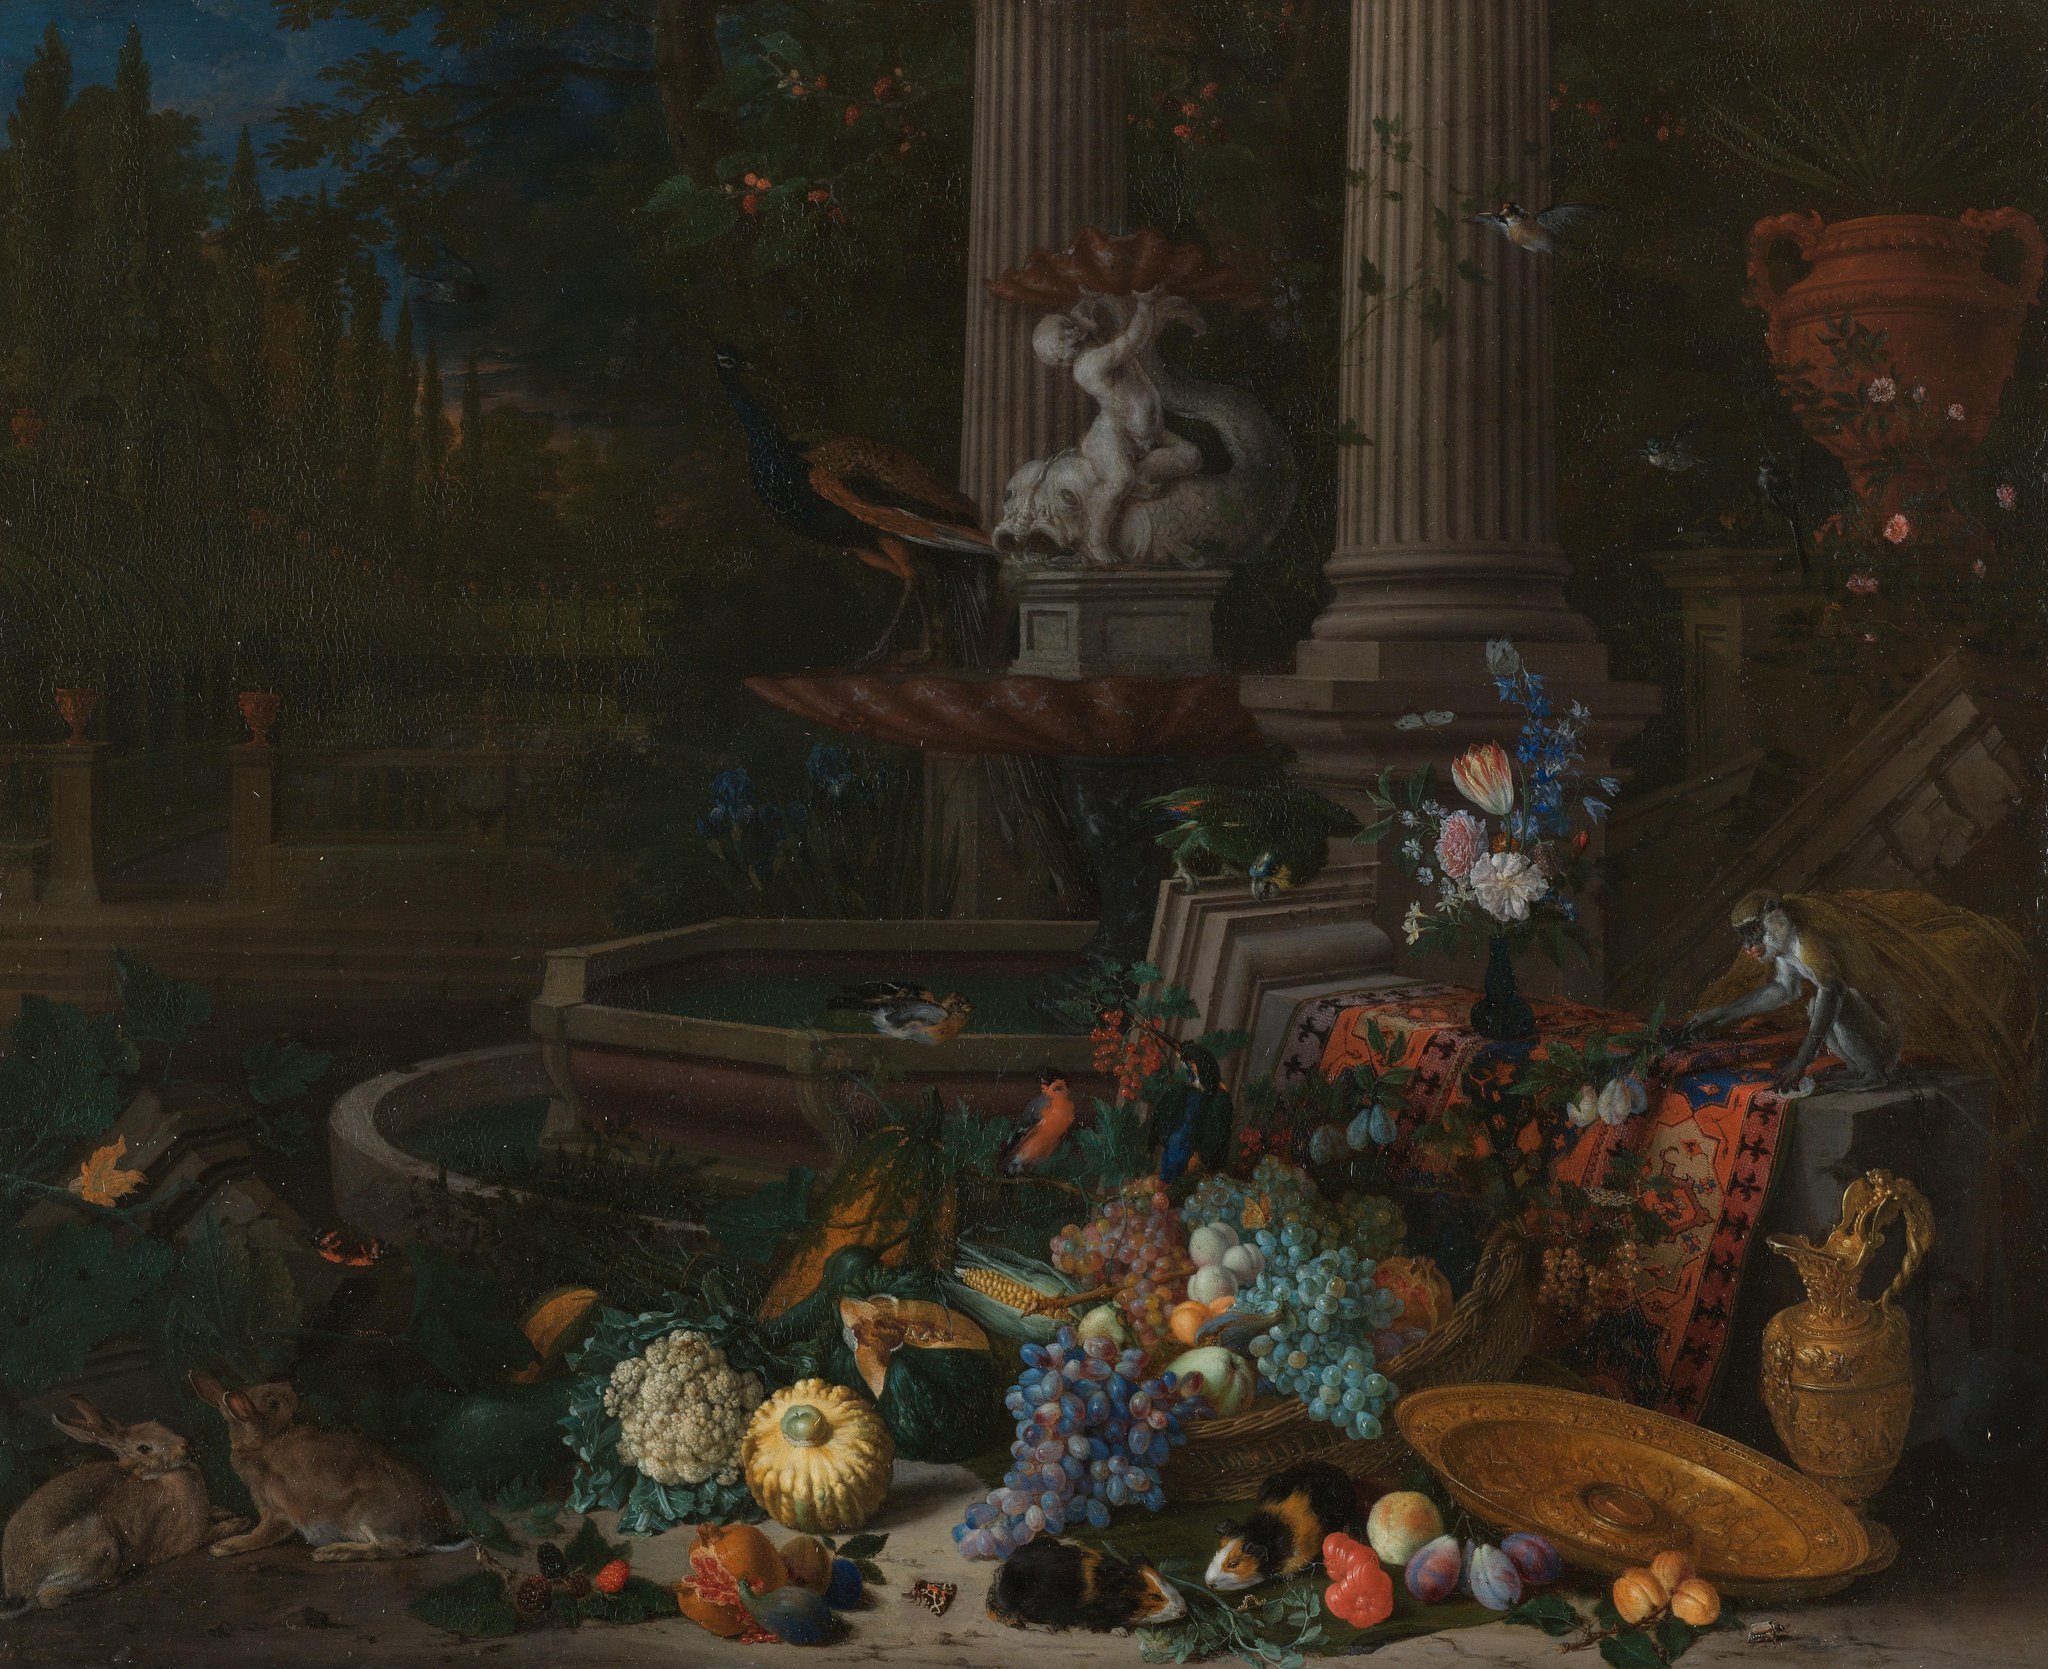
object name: painting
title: Still Life with Vegetables before a Draped, Overturned Plinth by an Ornamental Fountain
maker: peeter gijsels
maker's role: draughtsman, painter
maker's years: 1621-1690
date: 1680-1690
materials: copper, oil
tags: monkeys, apes, carpet, rug, garden fountain, still life of plants, flowers and fruit, rodents: rabbit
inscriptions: signature, bottom right: ‘[…]ER / […]SELS’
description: Stilleven van bloemen, vruchten en vaatwerk bij een fontein met een putto op een dolfijn, tussen zuilen. Linksonder twee hazen, een bloemkool en een kalebas, druiven, maïs, abrikozen, appels en aalbessen. Rechts een gouden lampetstel en een aapje (meerkat). Tussen de vruchten zitten allerlei vogeltjes, vlinders en andere insecten.